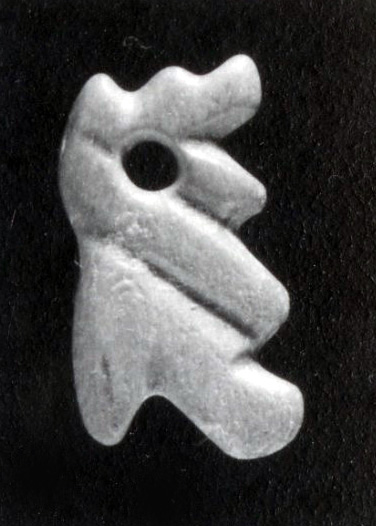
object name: amulet, taweret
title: Taweret amulet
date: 2110-2030 BCE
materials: ivory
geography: egypt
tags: taweret